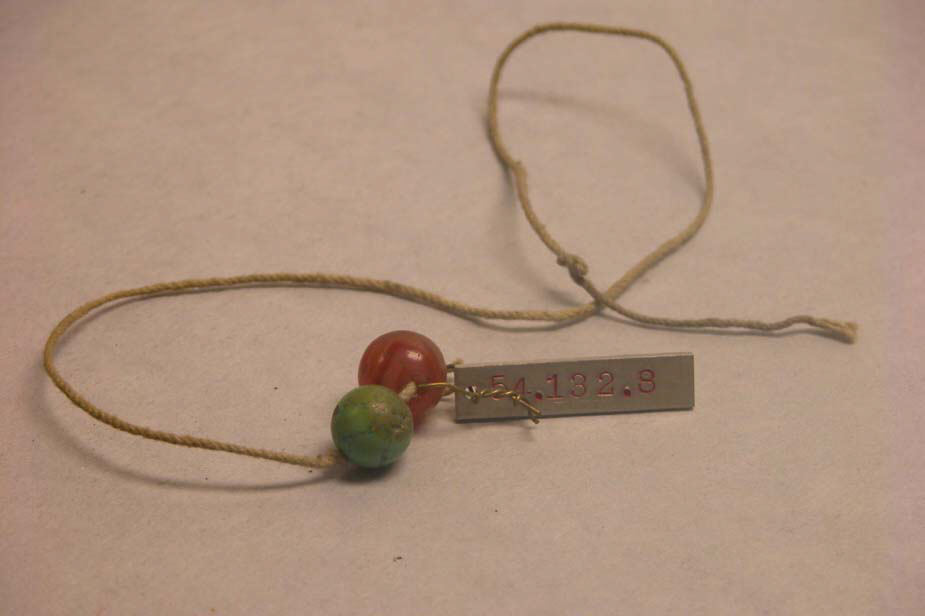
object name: two bead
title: Two Beads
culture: tibetan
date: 1801-1900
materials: jade, silver